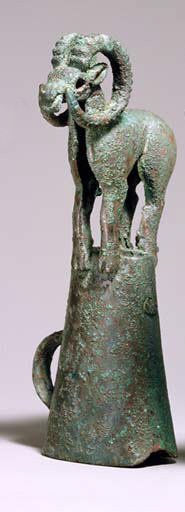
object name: finial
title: Finial with Wild Ram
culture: chinese, northeast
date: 700-501 BCE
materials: bronze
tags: rams